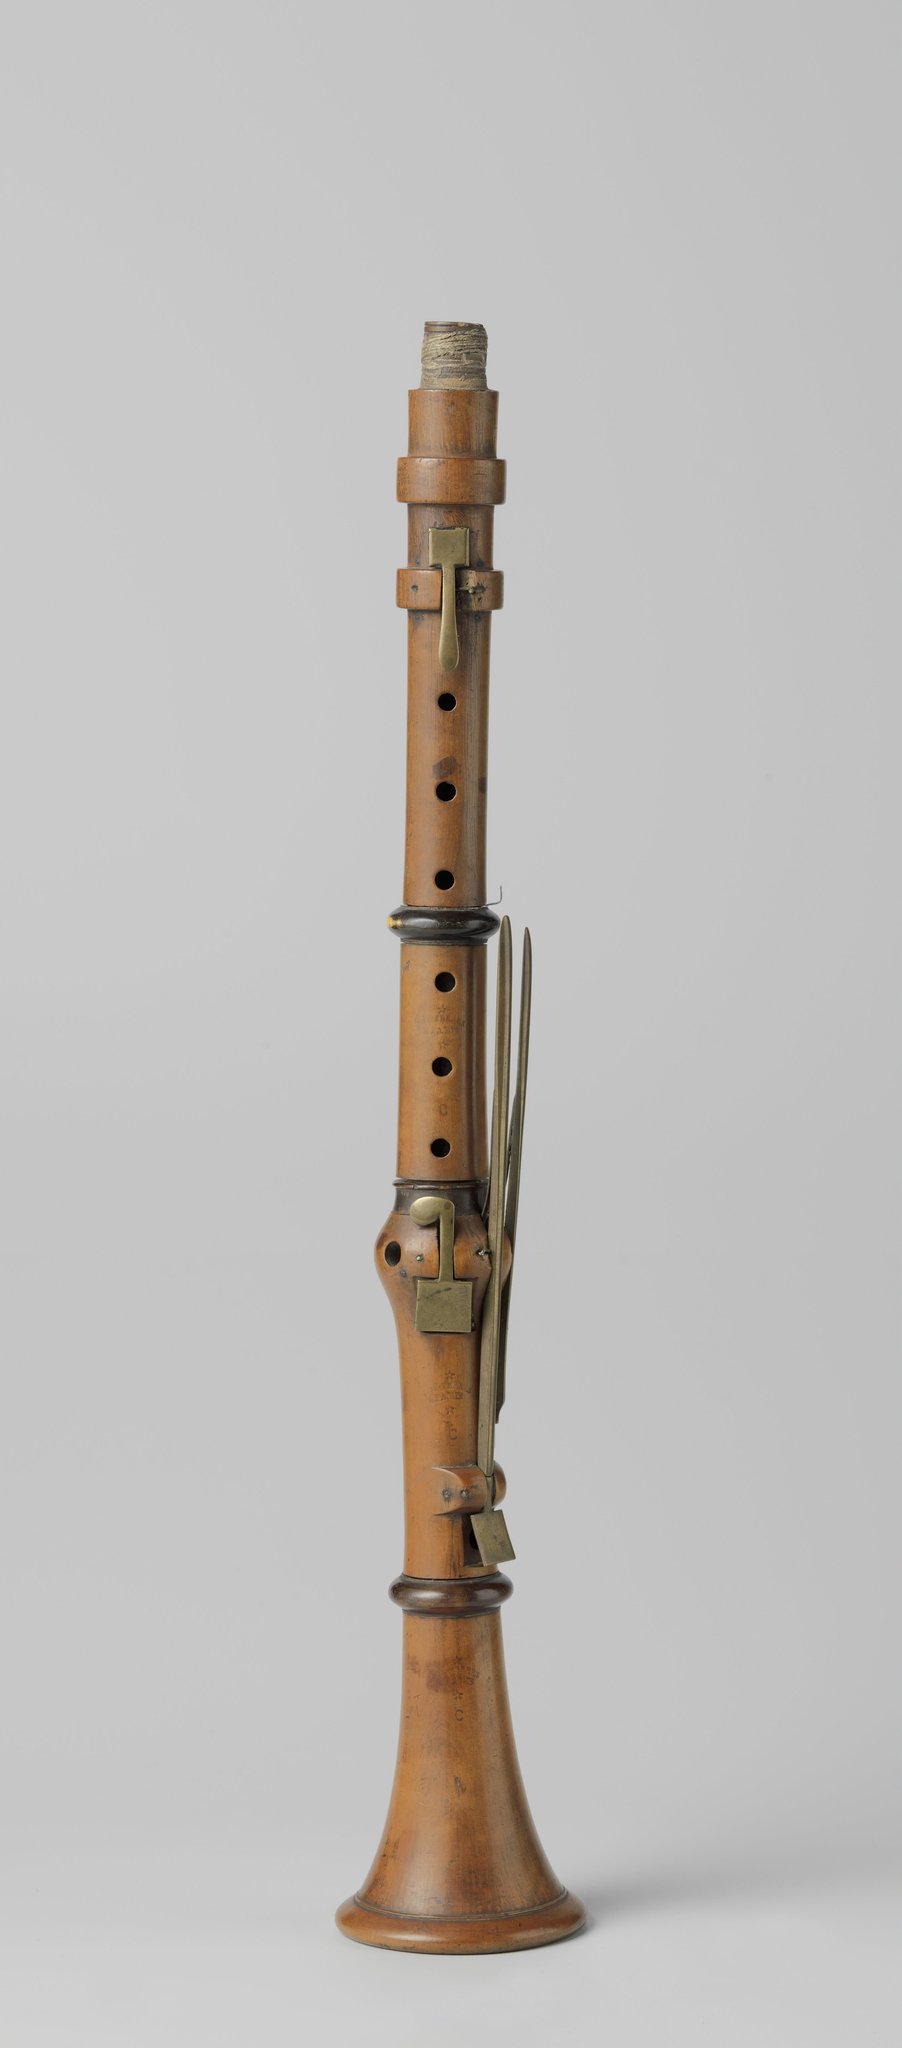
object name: wind instrument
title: Clarinet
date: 1800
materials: brass, wood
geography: paris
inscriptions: mark, on the middle, lower joint and on the bell, stamped: ‘NOE FRERES/ A PARIS’ [a star]/ NOE FRERES/ A PARIS/ [a star]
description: Klarinet in C in drie delen, van bruin palmhout met vijf vierkante messing kleppen en twee donkerbruine ringen.